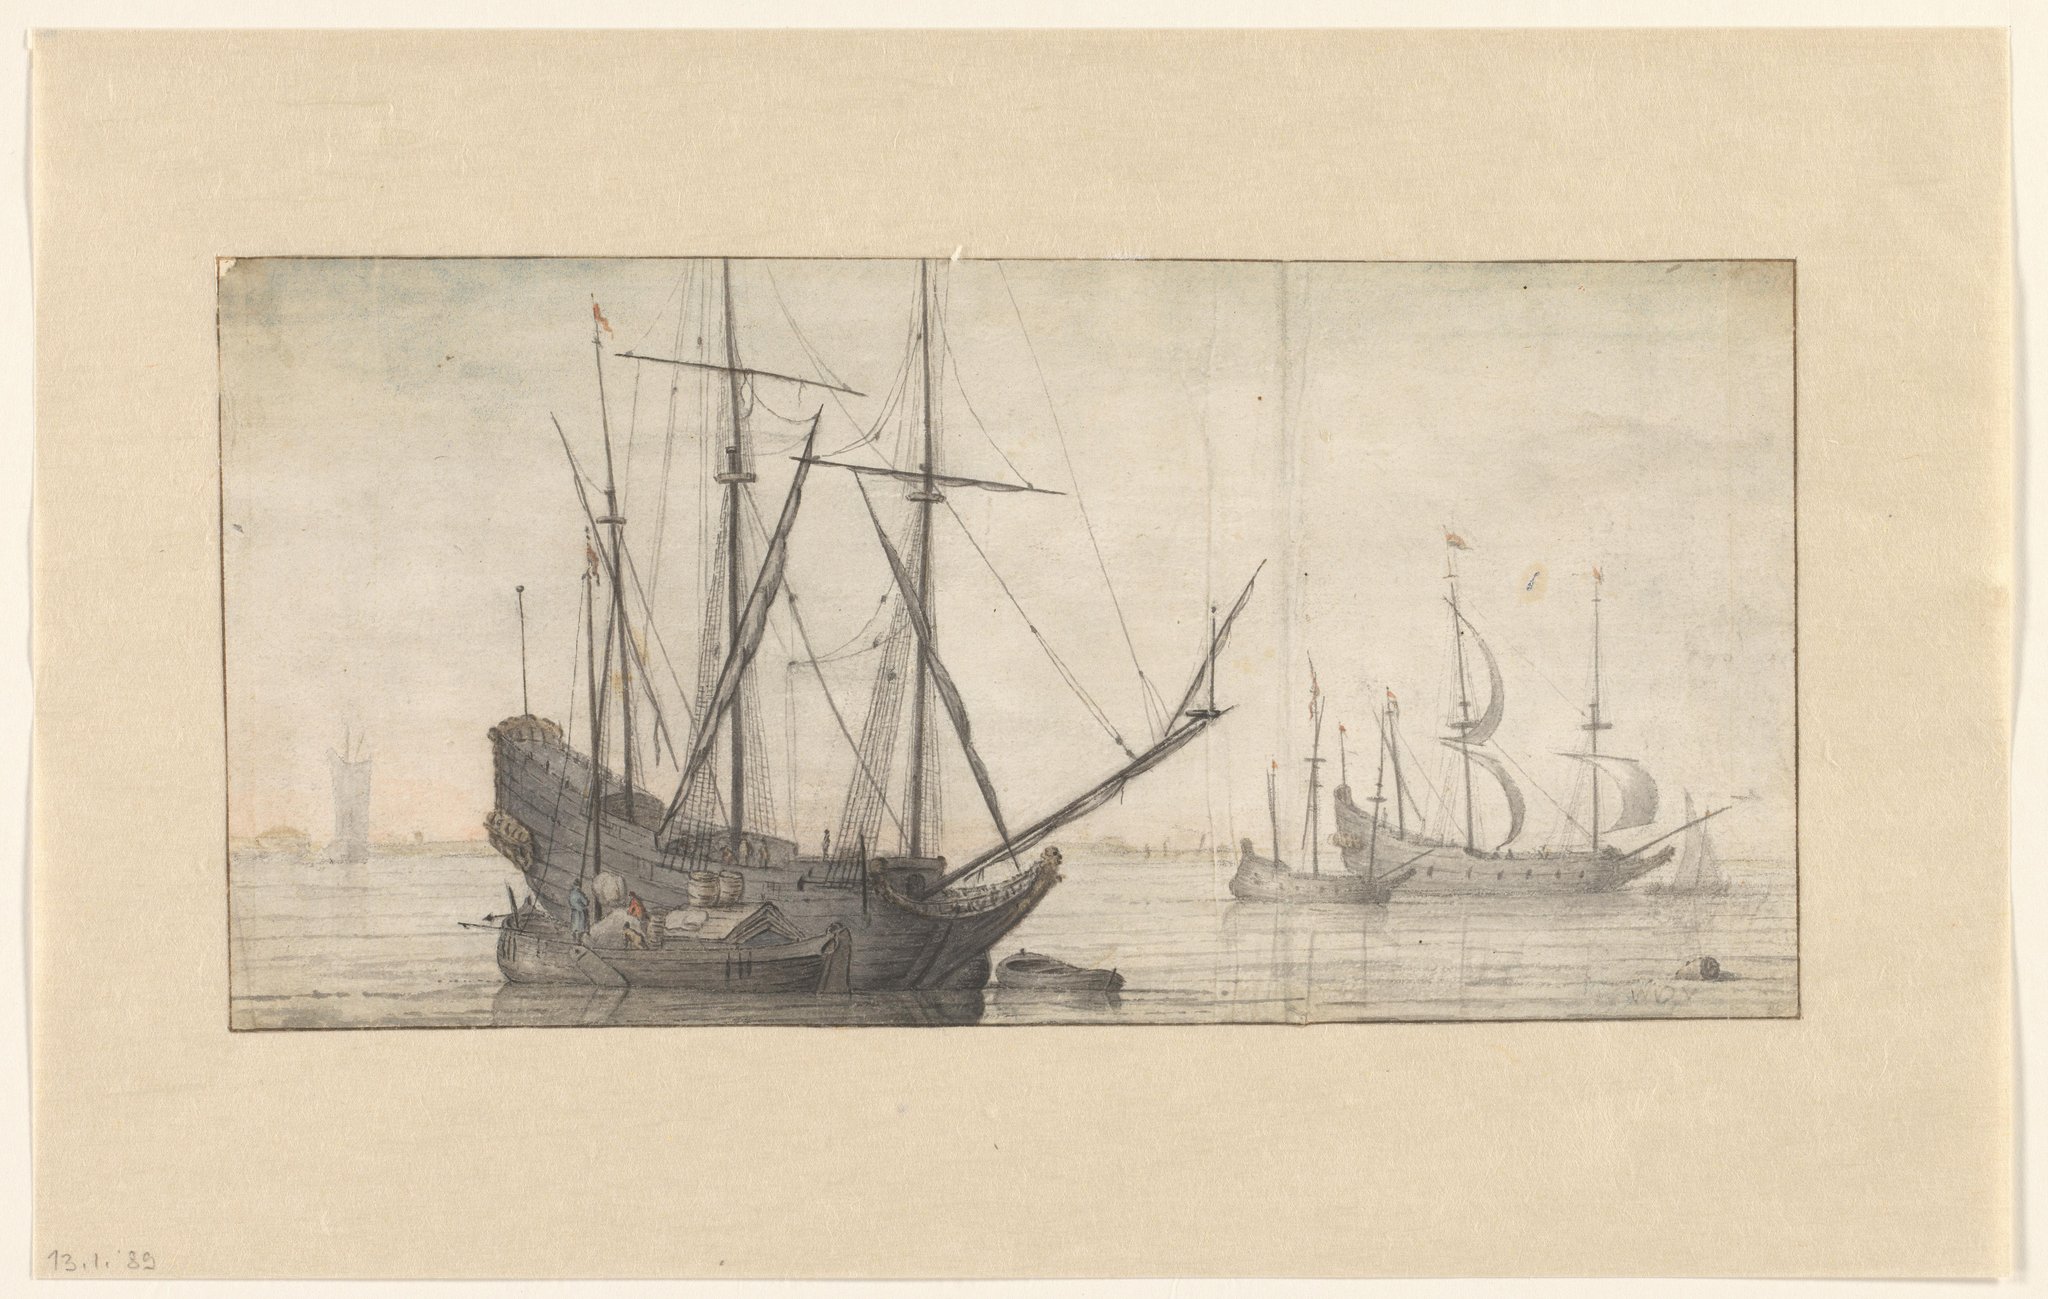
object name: drawing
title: Zeilschepen op stil water bij de kust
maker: abraham de verwer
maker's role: draughtsman, painter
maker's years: 1585-1650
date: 1600-1650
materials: chalk, ink, paper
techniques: brush, pen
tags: sailing-ship, sailing-boat, sea (seascape), ship in the roads, roadstead